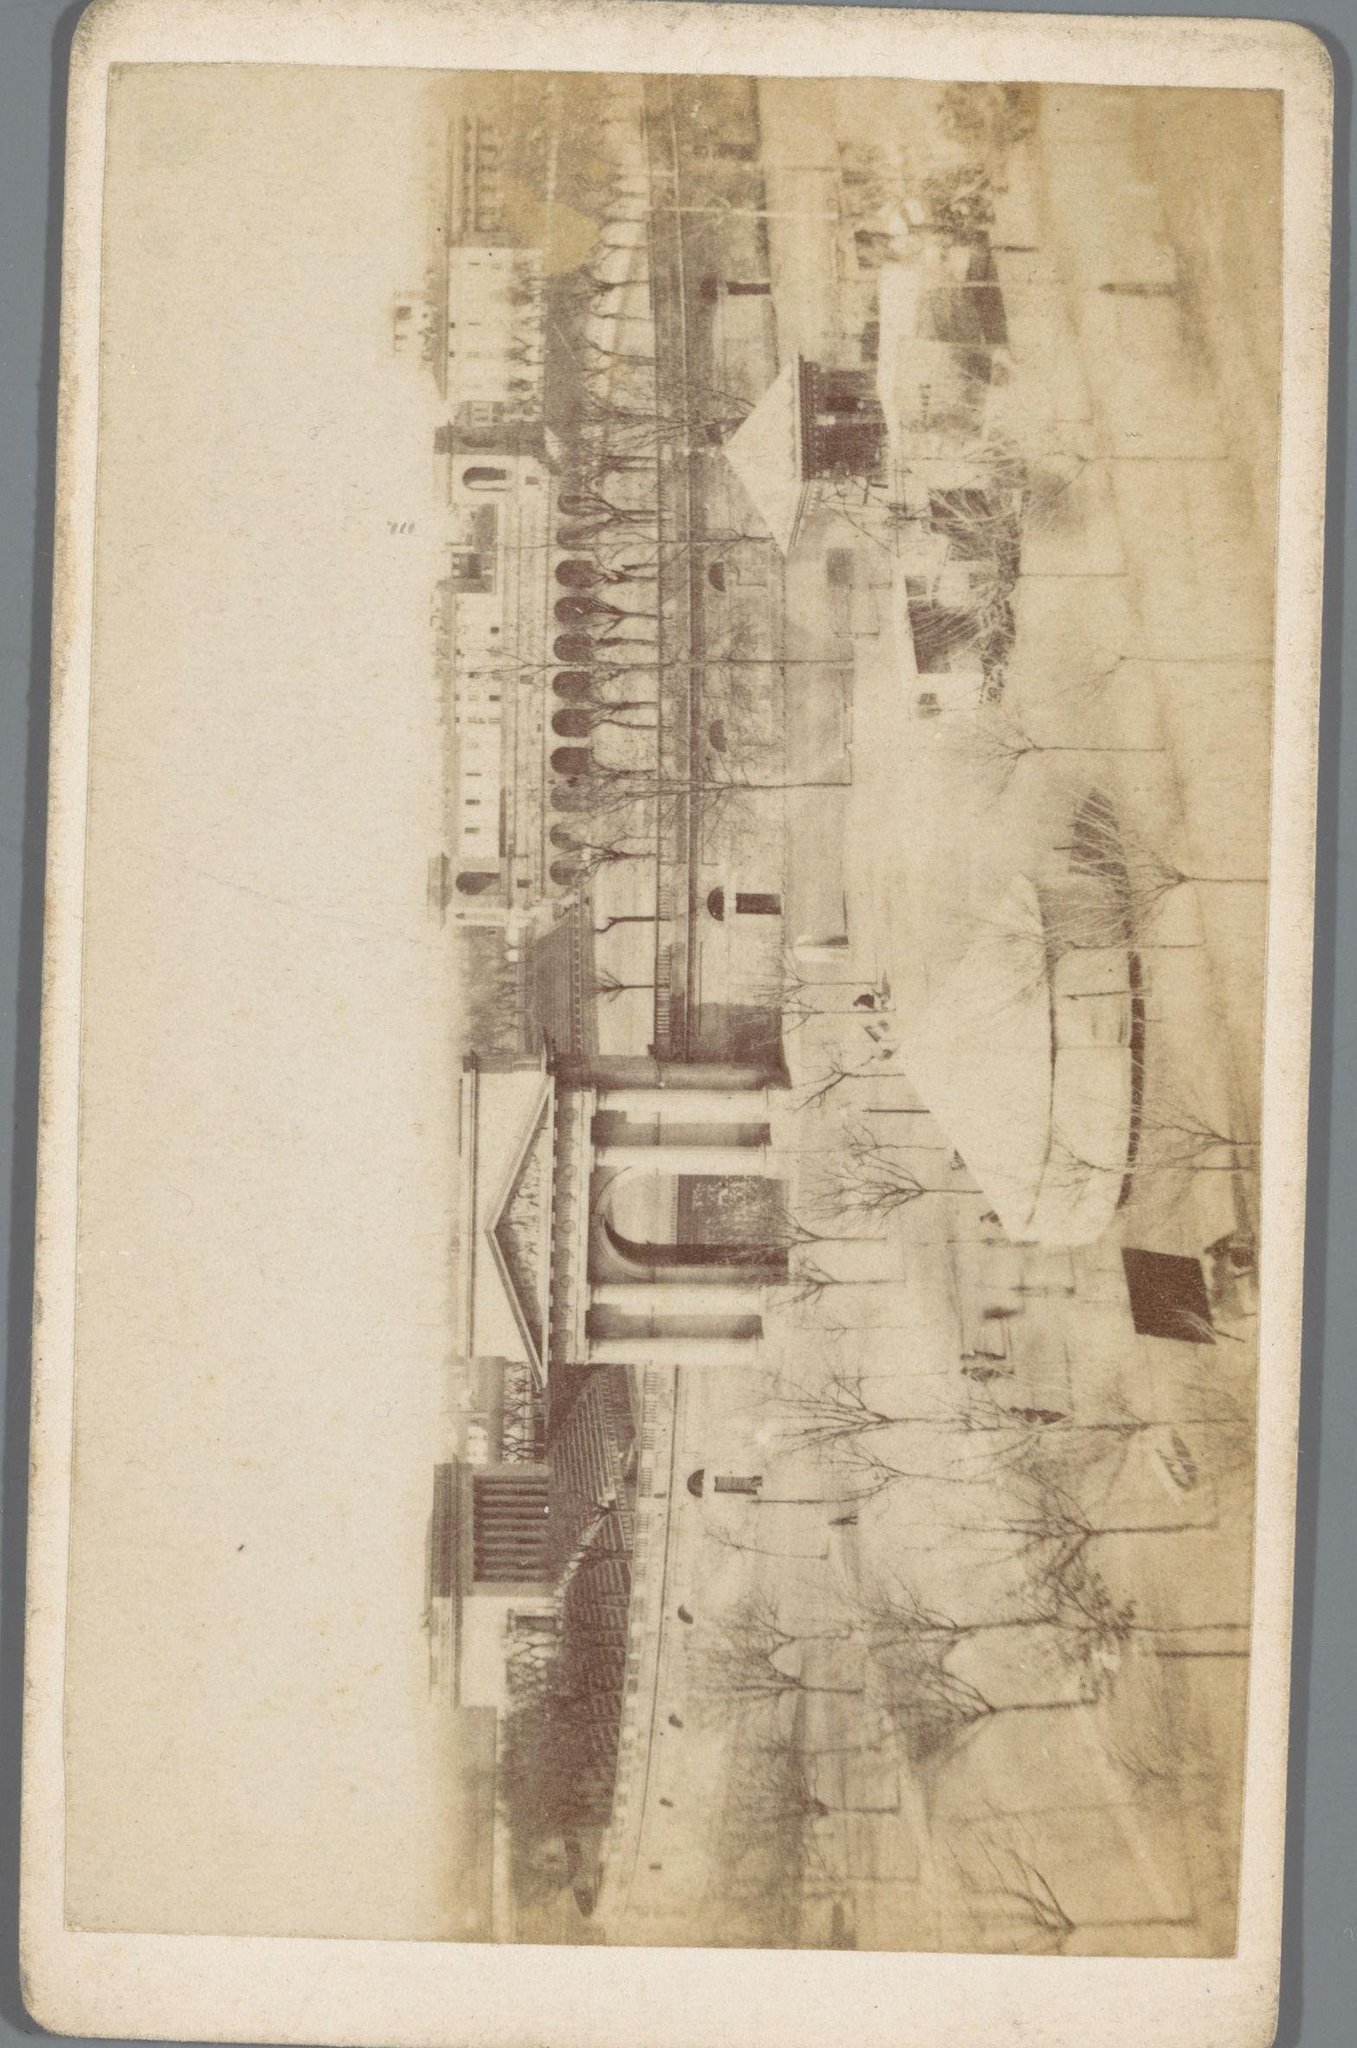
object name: photograph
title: Arena di Milano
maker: Anonymous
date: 1855-1885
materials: cardboard, paper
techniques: albumen print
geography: milan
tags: grounds, fields and accomodations for sports, games and physical performances